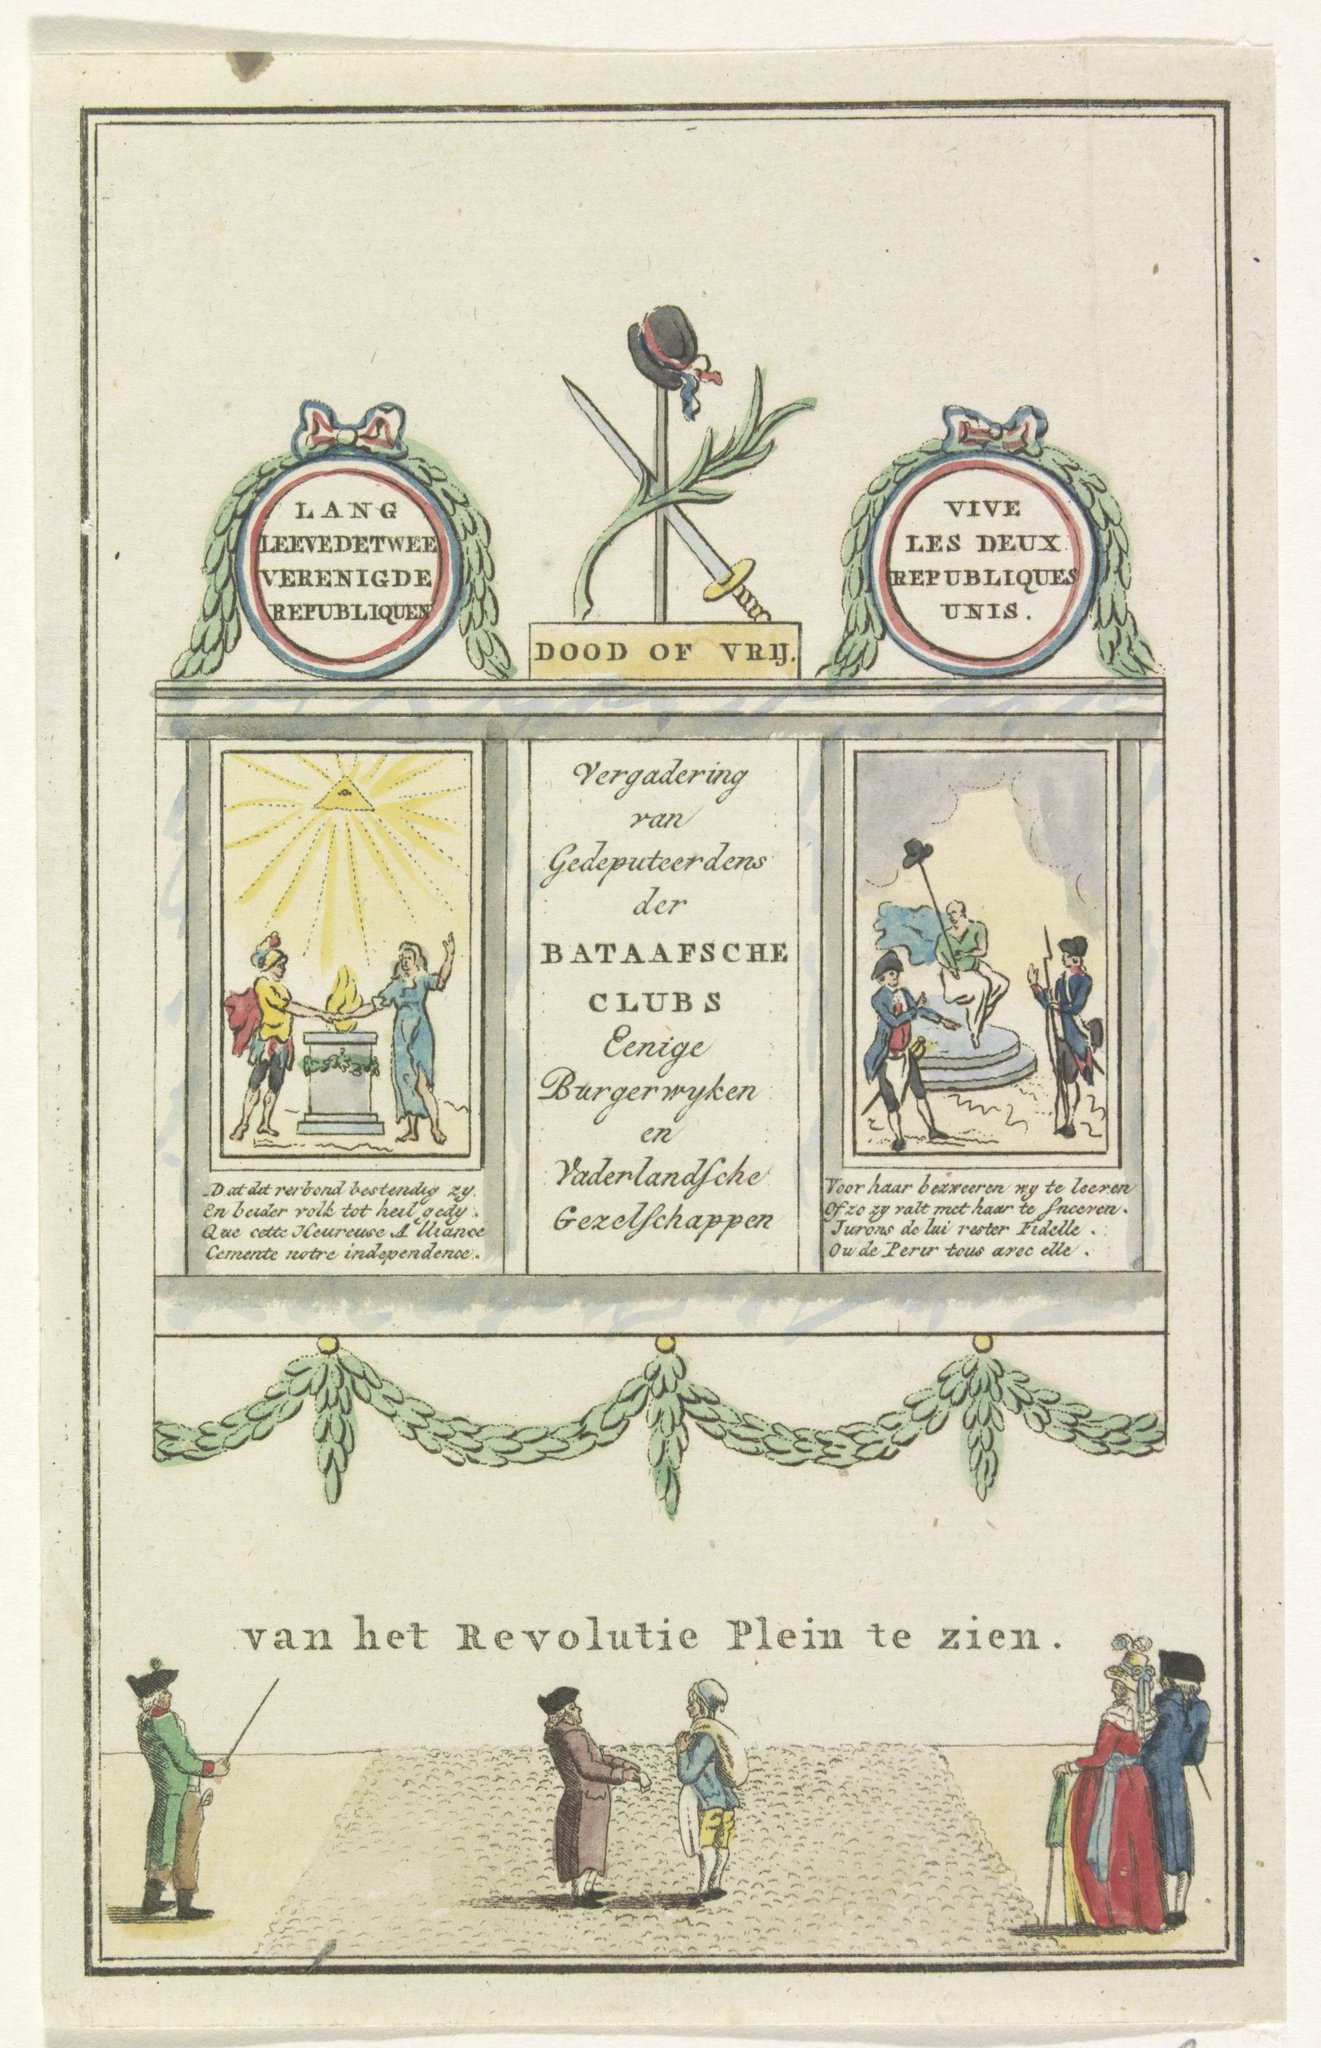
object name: print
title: Dood of Vrij / Vergadering van Gedeputeerden der Bataafsche Clubs, Eenige Burgerwyken en Vaderlandsche Gezelschappen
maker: noach van der meer (ii)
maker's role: draughtsman, print maker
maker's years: 1741-1822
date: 1795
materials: paper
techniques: etching, hand coloring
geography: netherlands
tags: festivities on events of national importance (+ festive decoration ~ festive activities), amsterdam, alliance with france (1795)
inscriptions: collector's mark: Lugt 2228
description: Decoratie in de Beurssteeg, gezien vanaf de Dam, 1795. Opgericht door een Vergadering van Gedeputeerden van de Bataafsche Clubs, Burgerwijken en Vaderlandsche Gezelschappen te Amsterdam. Met enkele figuren. Uit het boekje met afbeeldingen van de versieringen opgericht in de stad bij de viering van de installatie van de representanten en de alliantie gesloten tussen de Franse en de Bataafse Republiek, 19 juni 1795. Bij de prent behoort een los blad met uitleg.